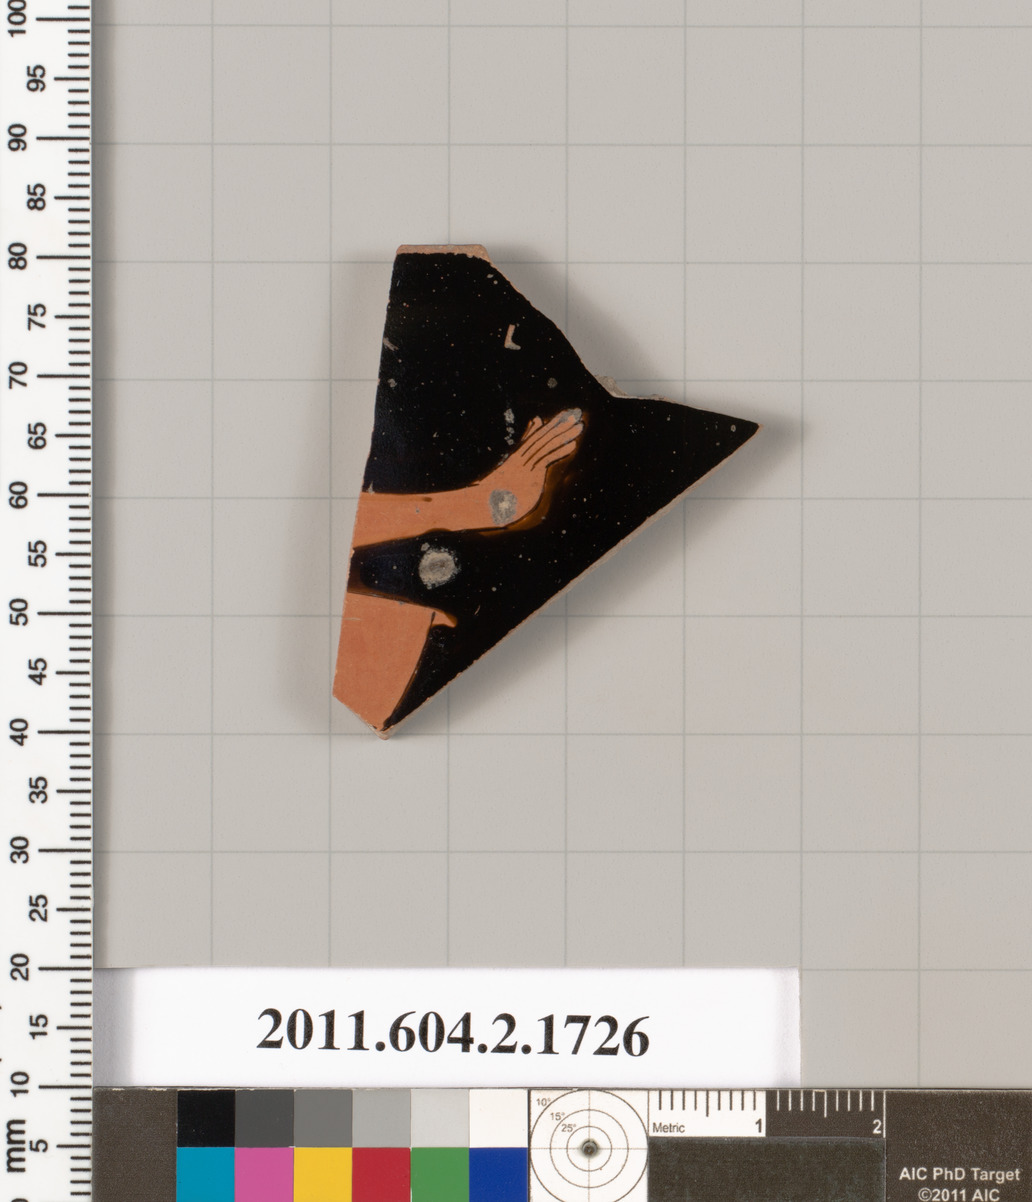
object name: skyphos fragment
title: Terracotta rim fragment of a skyphos (deep drinking cup)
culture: greek, attic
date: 480-470 BCE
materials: terracotta